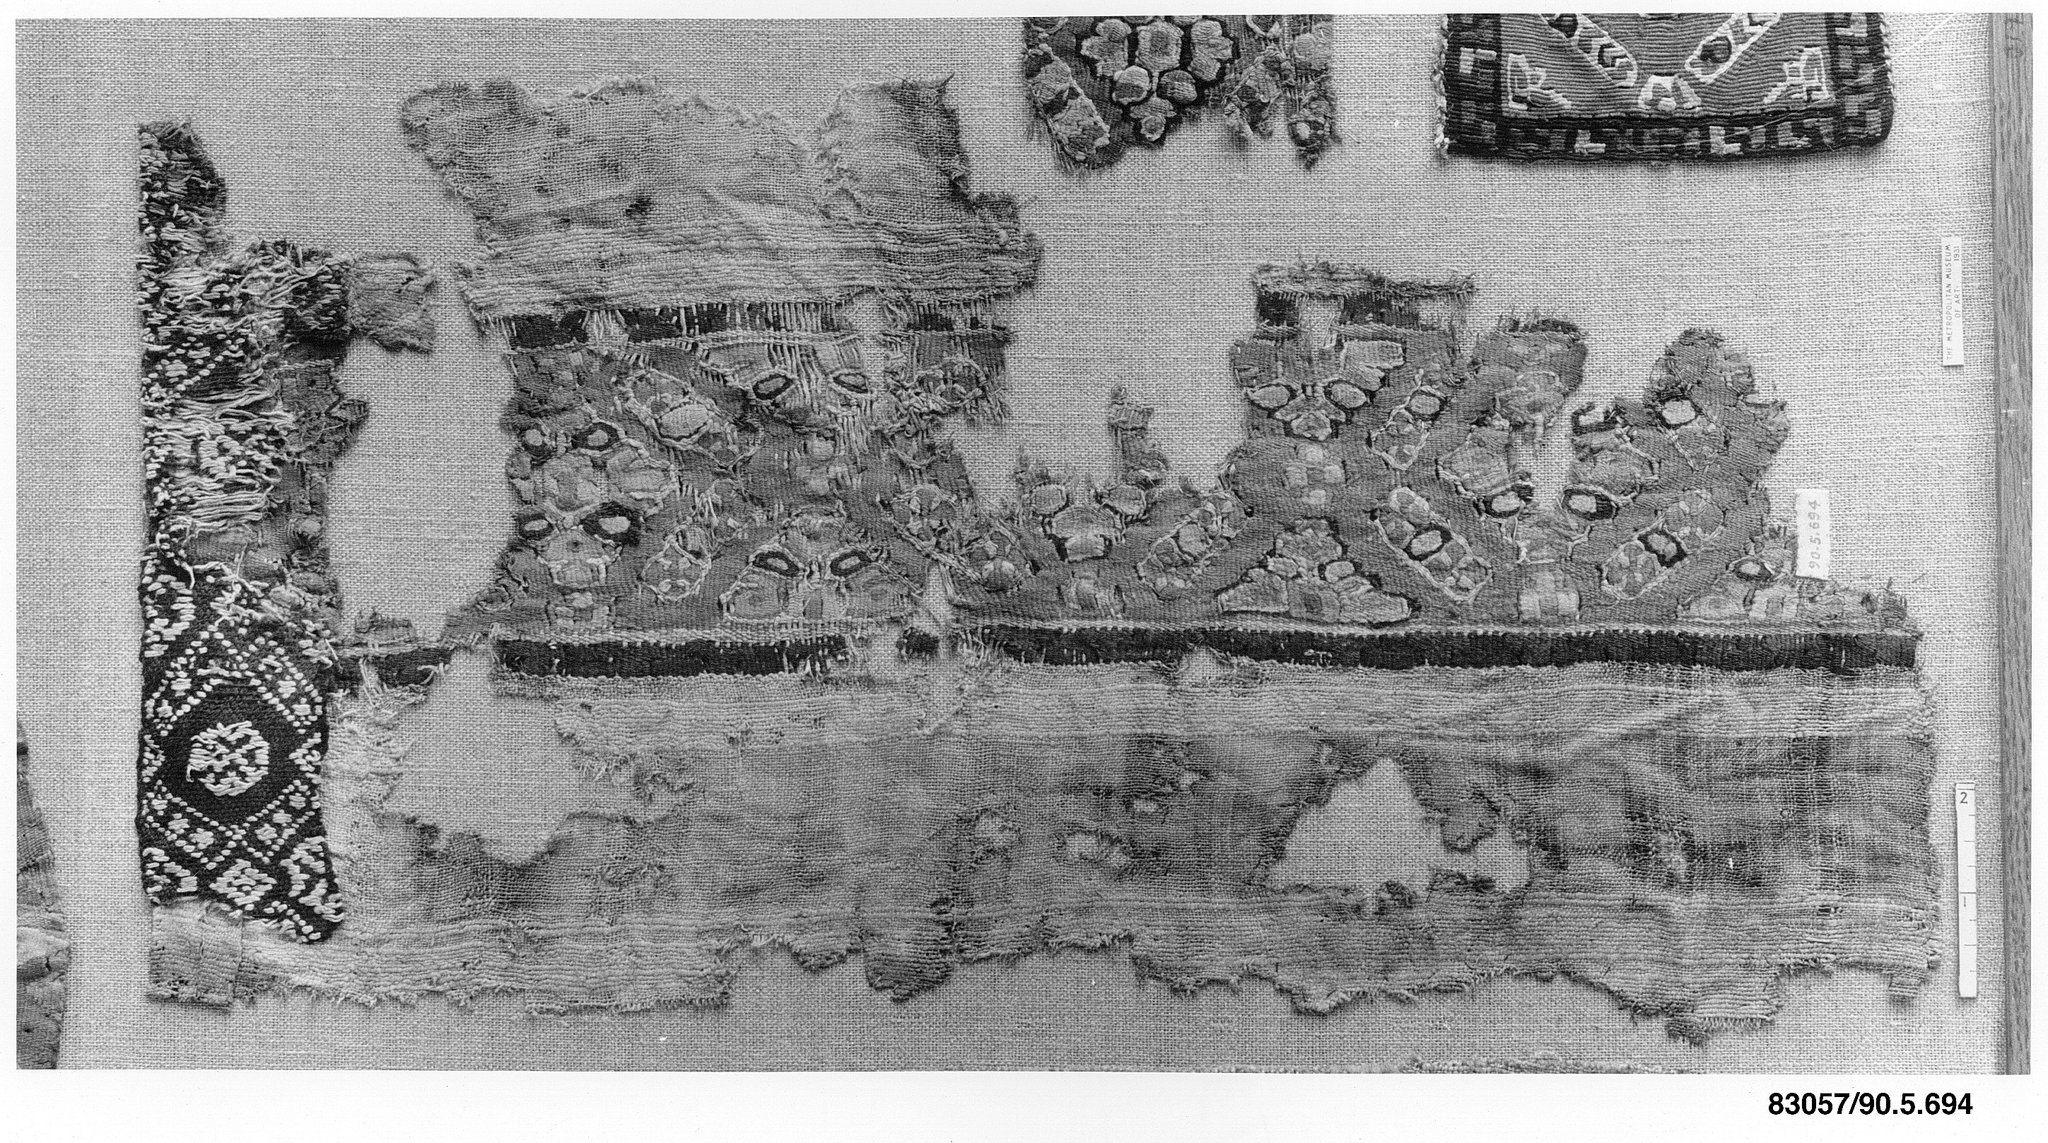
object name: textile fragment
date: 501-600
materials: linen, wool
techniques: weave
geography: egypt